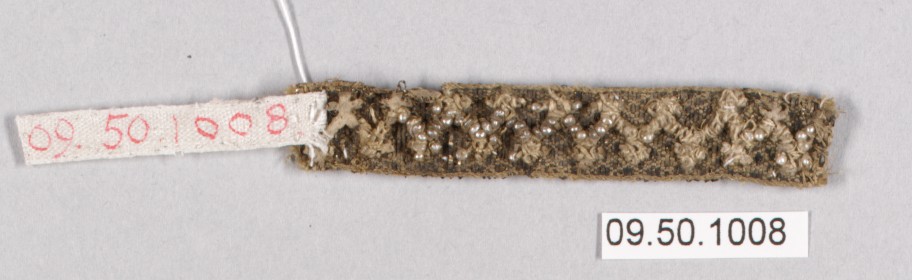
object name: gimp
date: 1701-1900